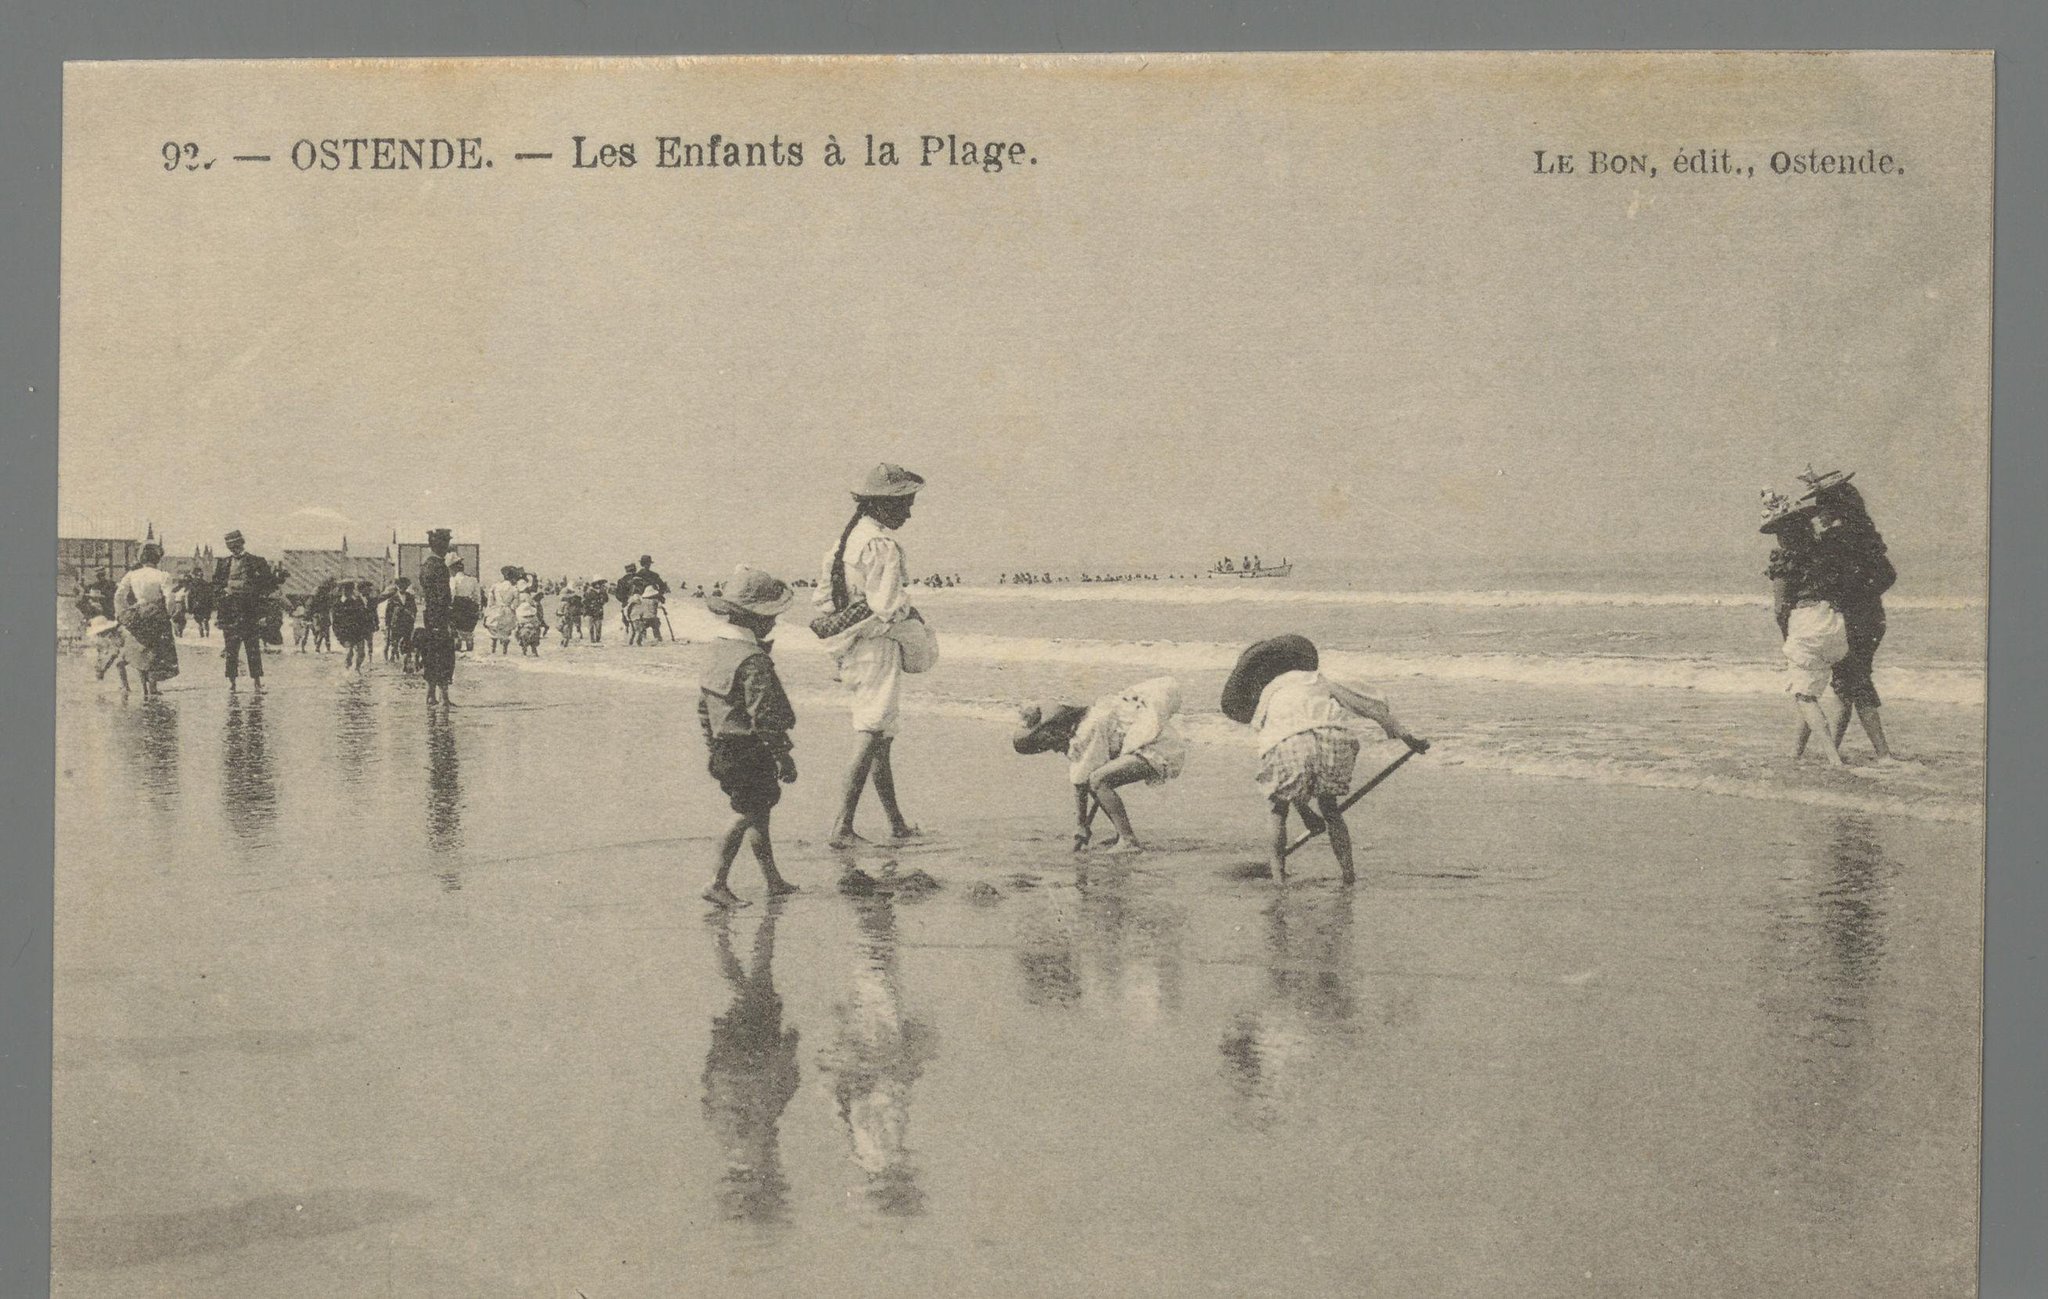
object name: ansichtkaart, prentbriefkaart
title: Ostende. Les enfants à la plage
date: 1906-1914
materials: cardboard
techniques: photograph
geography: oostende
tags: beach (as place of recreation), children's games and plays